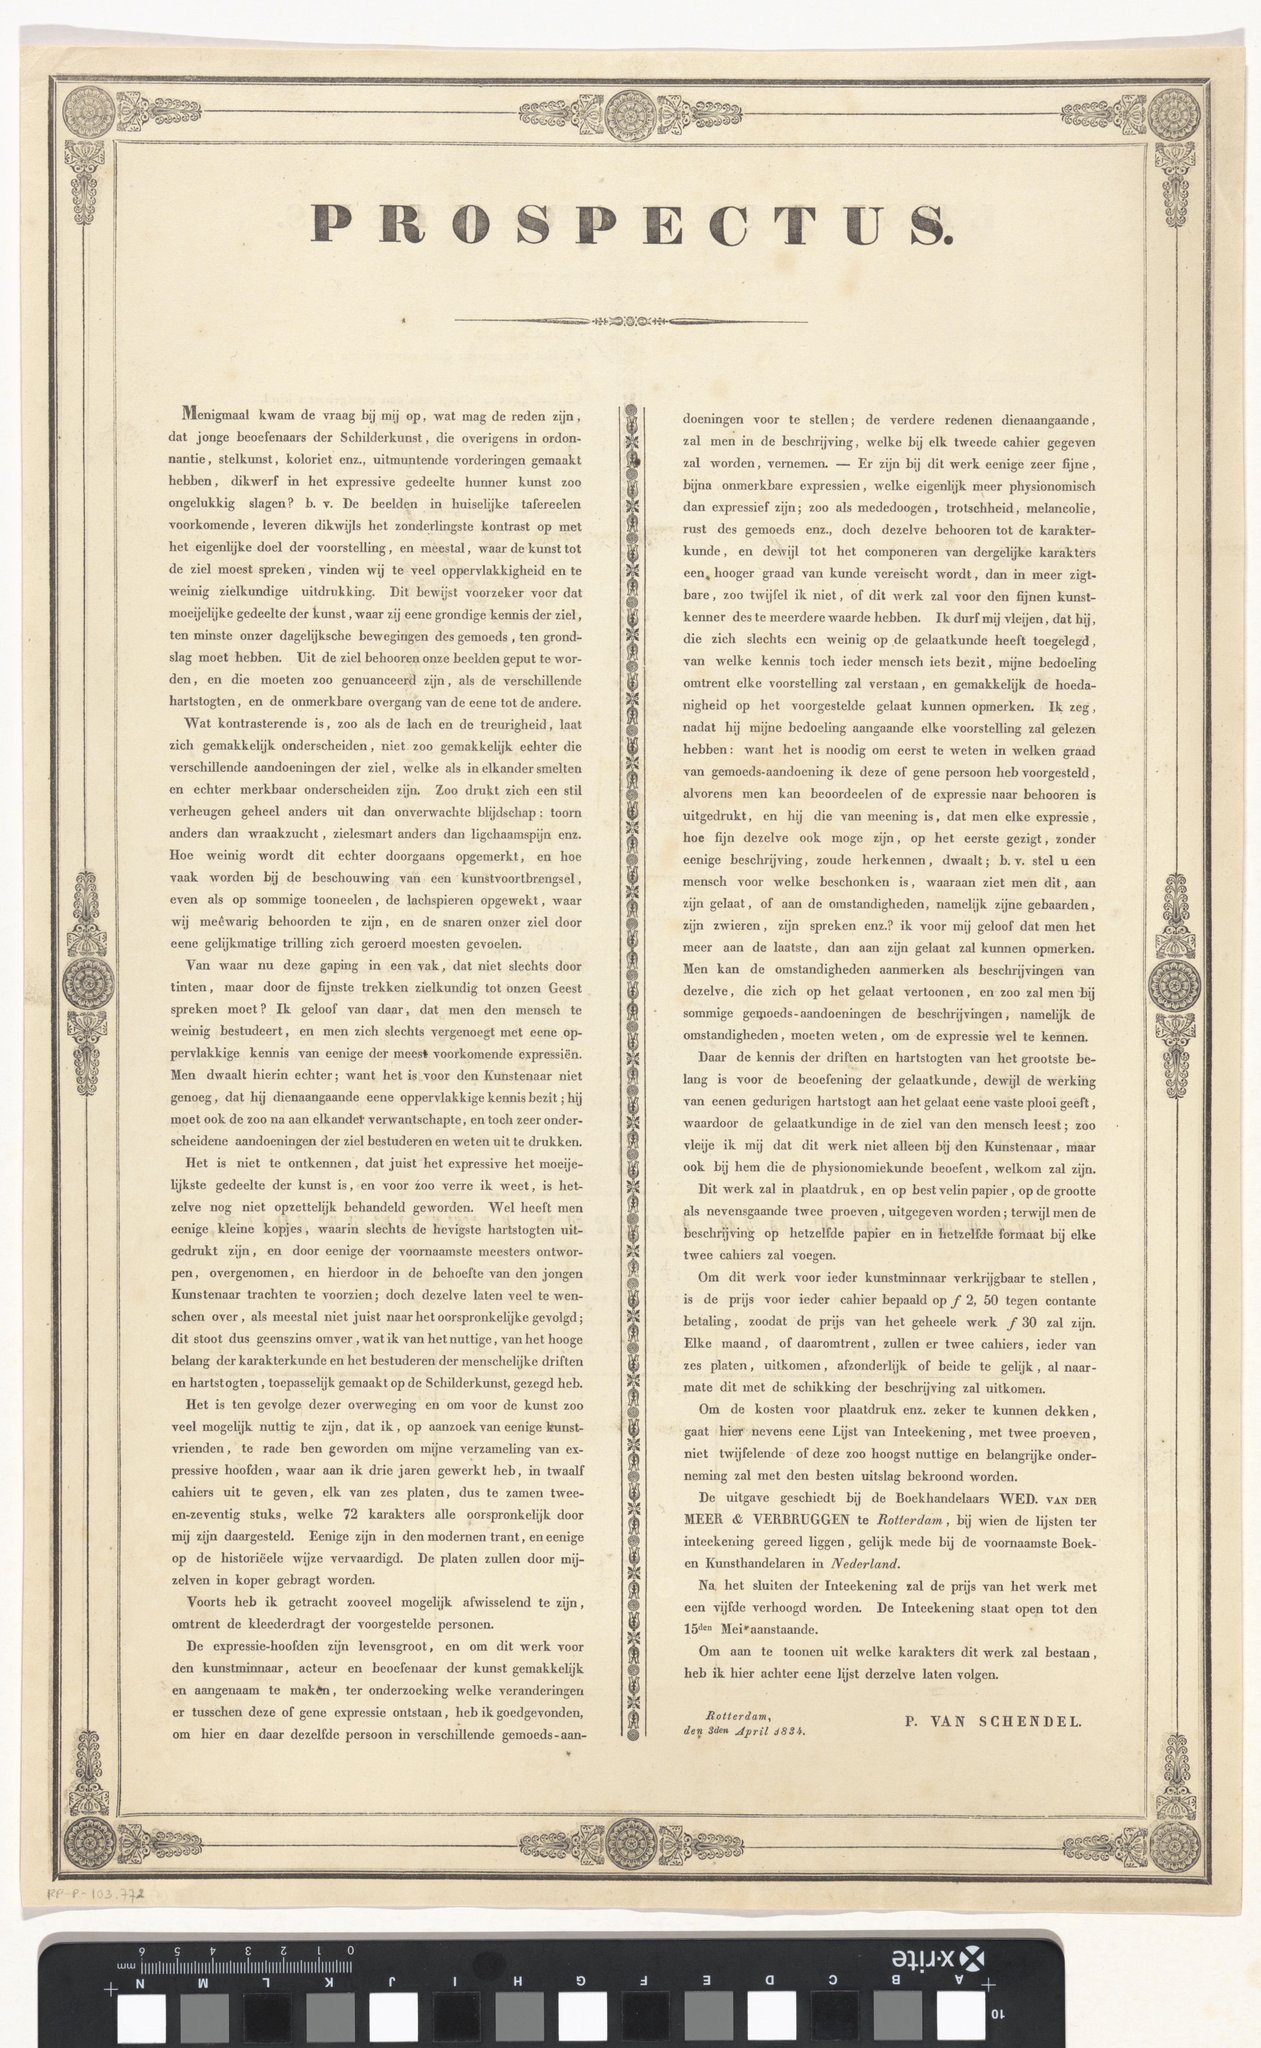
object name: print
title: Prospectus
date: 1834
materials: paper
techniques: letterpress printing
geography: rotterdam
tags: single printed leaf: broadsheet, leaflet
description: Prent was samen met twee proefdrukken bedoeld om potentiële afnemers te interesseren voor het werk: Schendel, Petrus van. De hartstogten, afgebeeld in 72 expressiehoofden, Rotterdam: Wed. van der Meer & Verbruggen, 1834